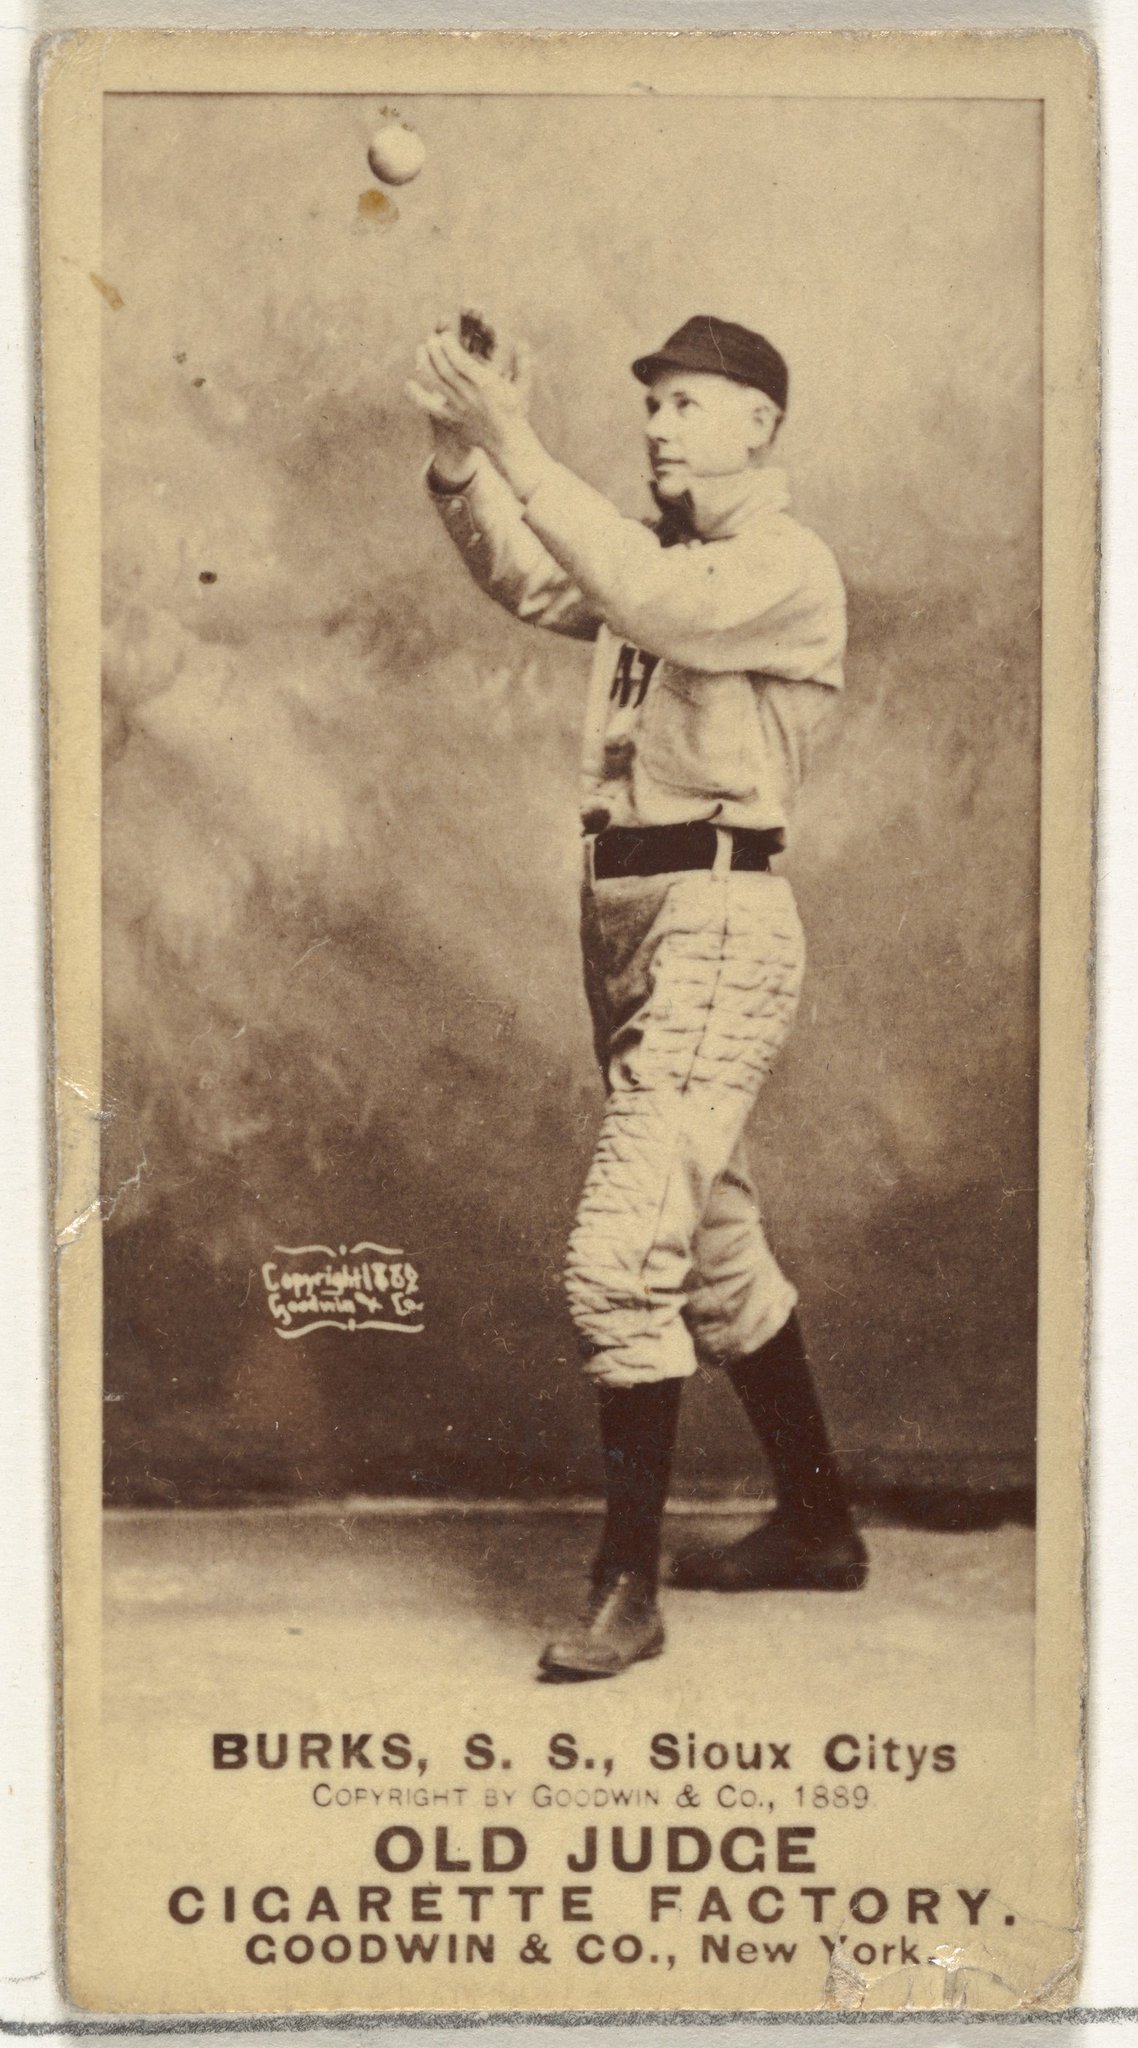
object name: baseball card, photograph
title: Robert E. Burks, Shortstop, Sioux City Corn Huskers, from the Old Judge series (N172) for Old Judge Cigarettes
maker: goodwin & company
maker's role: publisher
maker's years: 1850-1950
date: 1889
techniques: albumen silver print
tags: men,portraits,baseball,athletes